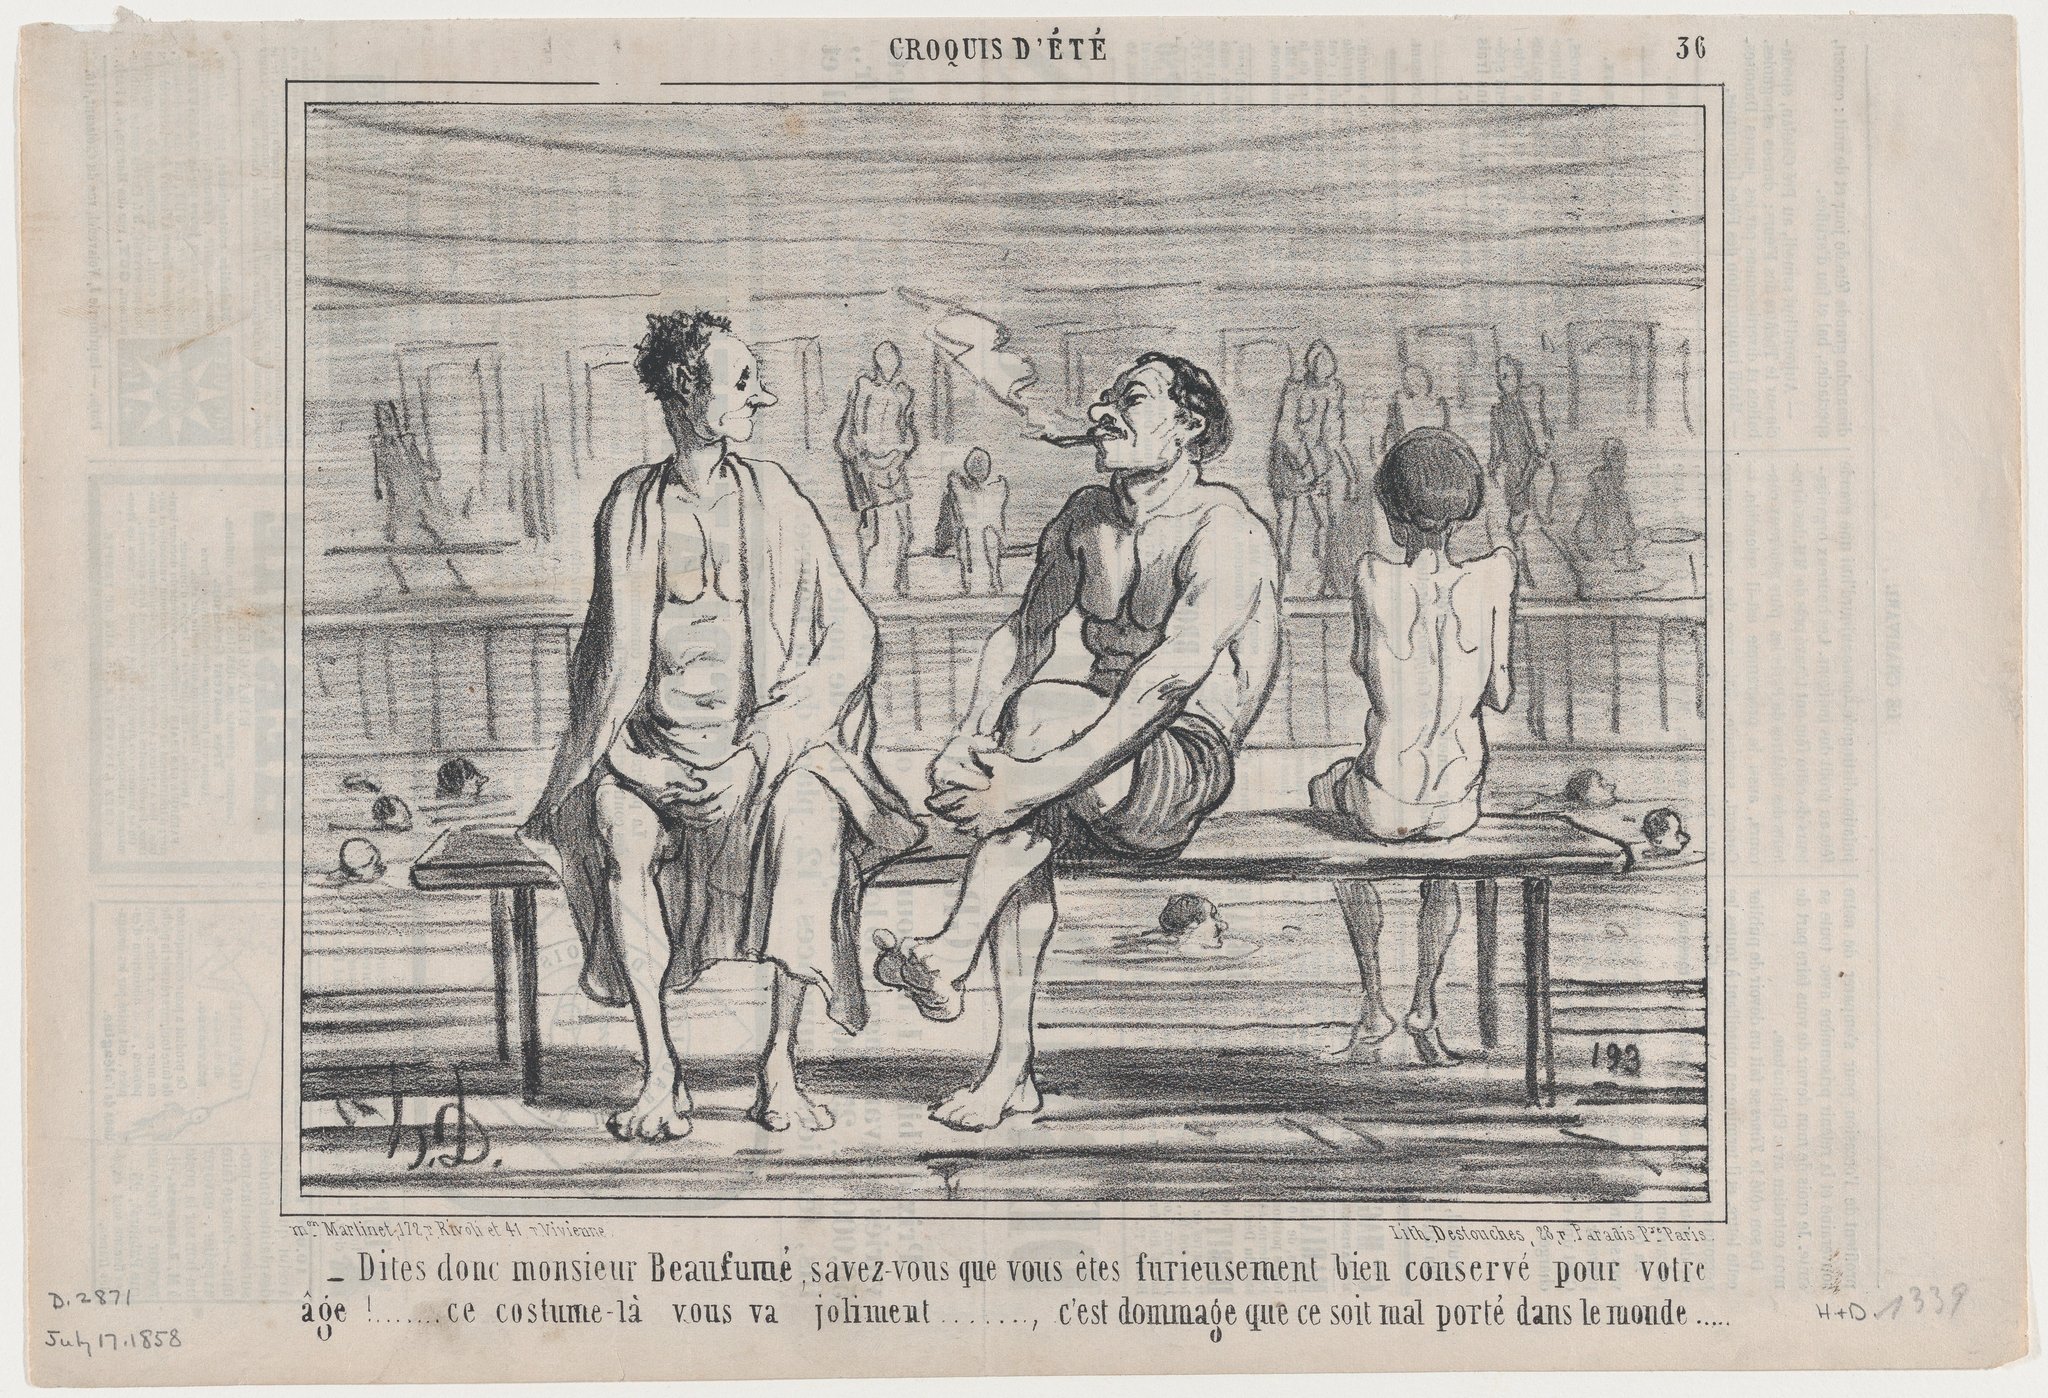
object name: print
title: Dites donc monsieur Beaufumé..., from Croquis d'Été, published in Le Charivari, July 17, 1858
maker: honoré daumier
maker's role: artist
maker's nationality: french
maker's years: 1808-1879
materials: paper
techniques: lithograph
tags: men,smoking,swimming,summer